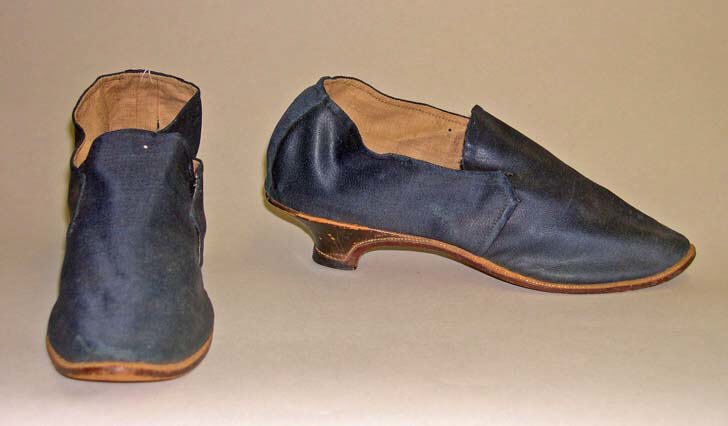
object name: shoe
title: Shoes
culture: american or european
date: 1801-1900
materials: cotton, leather